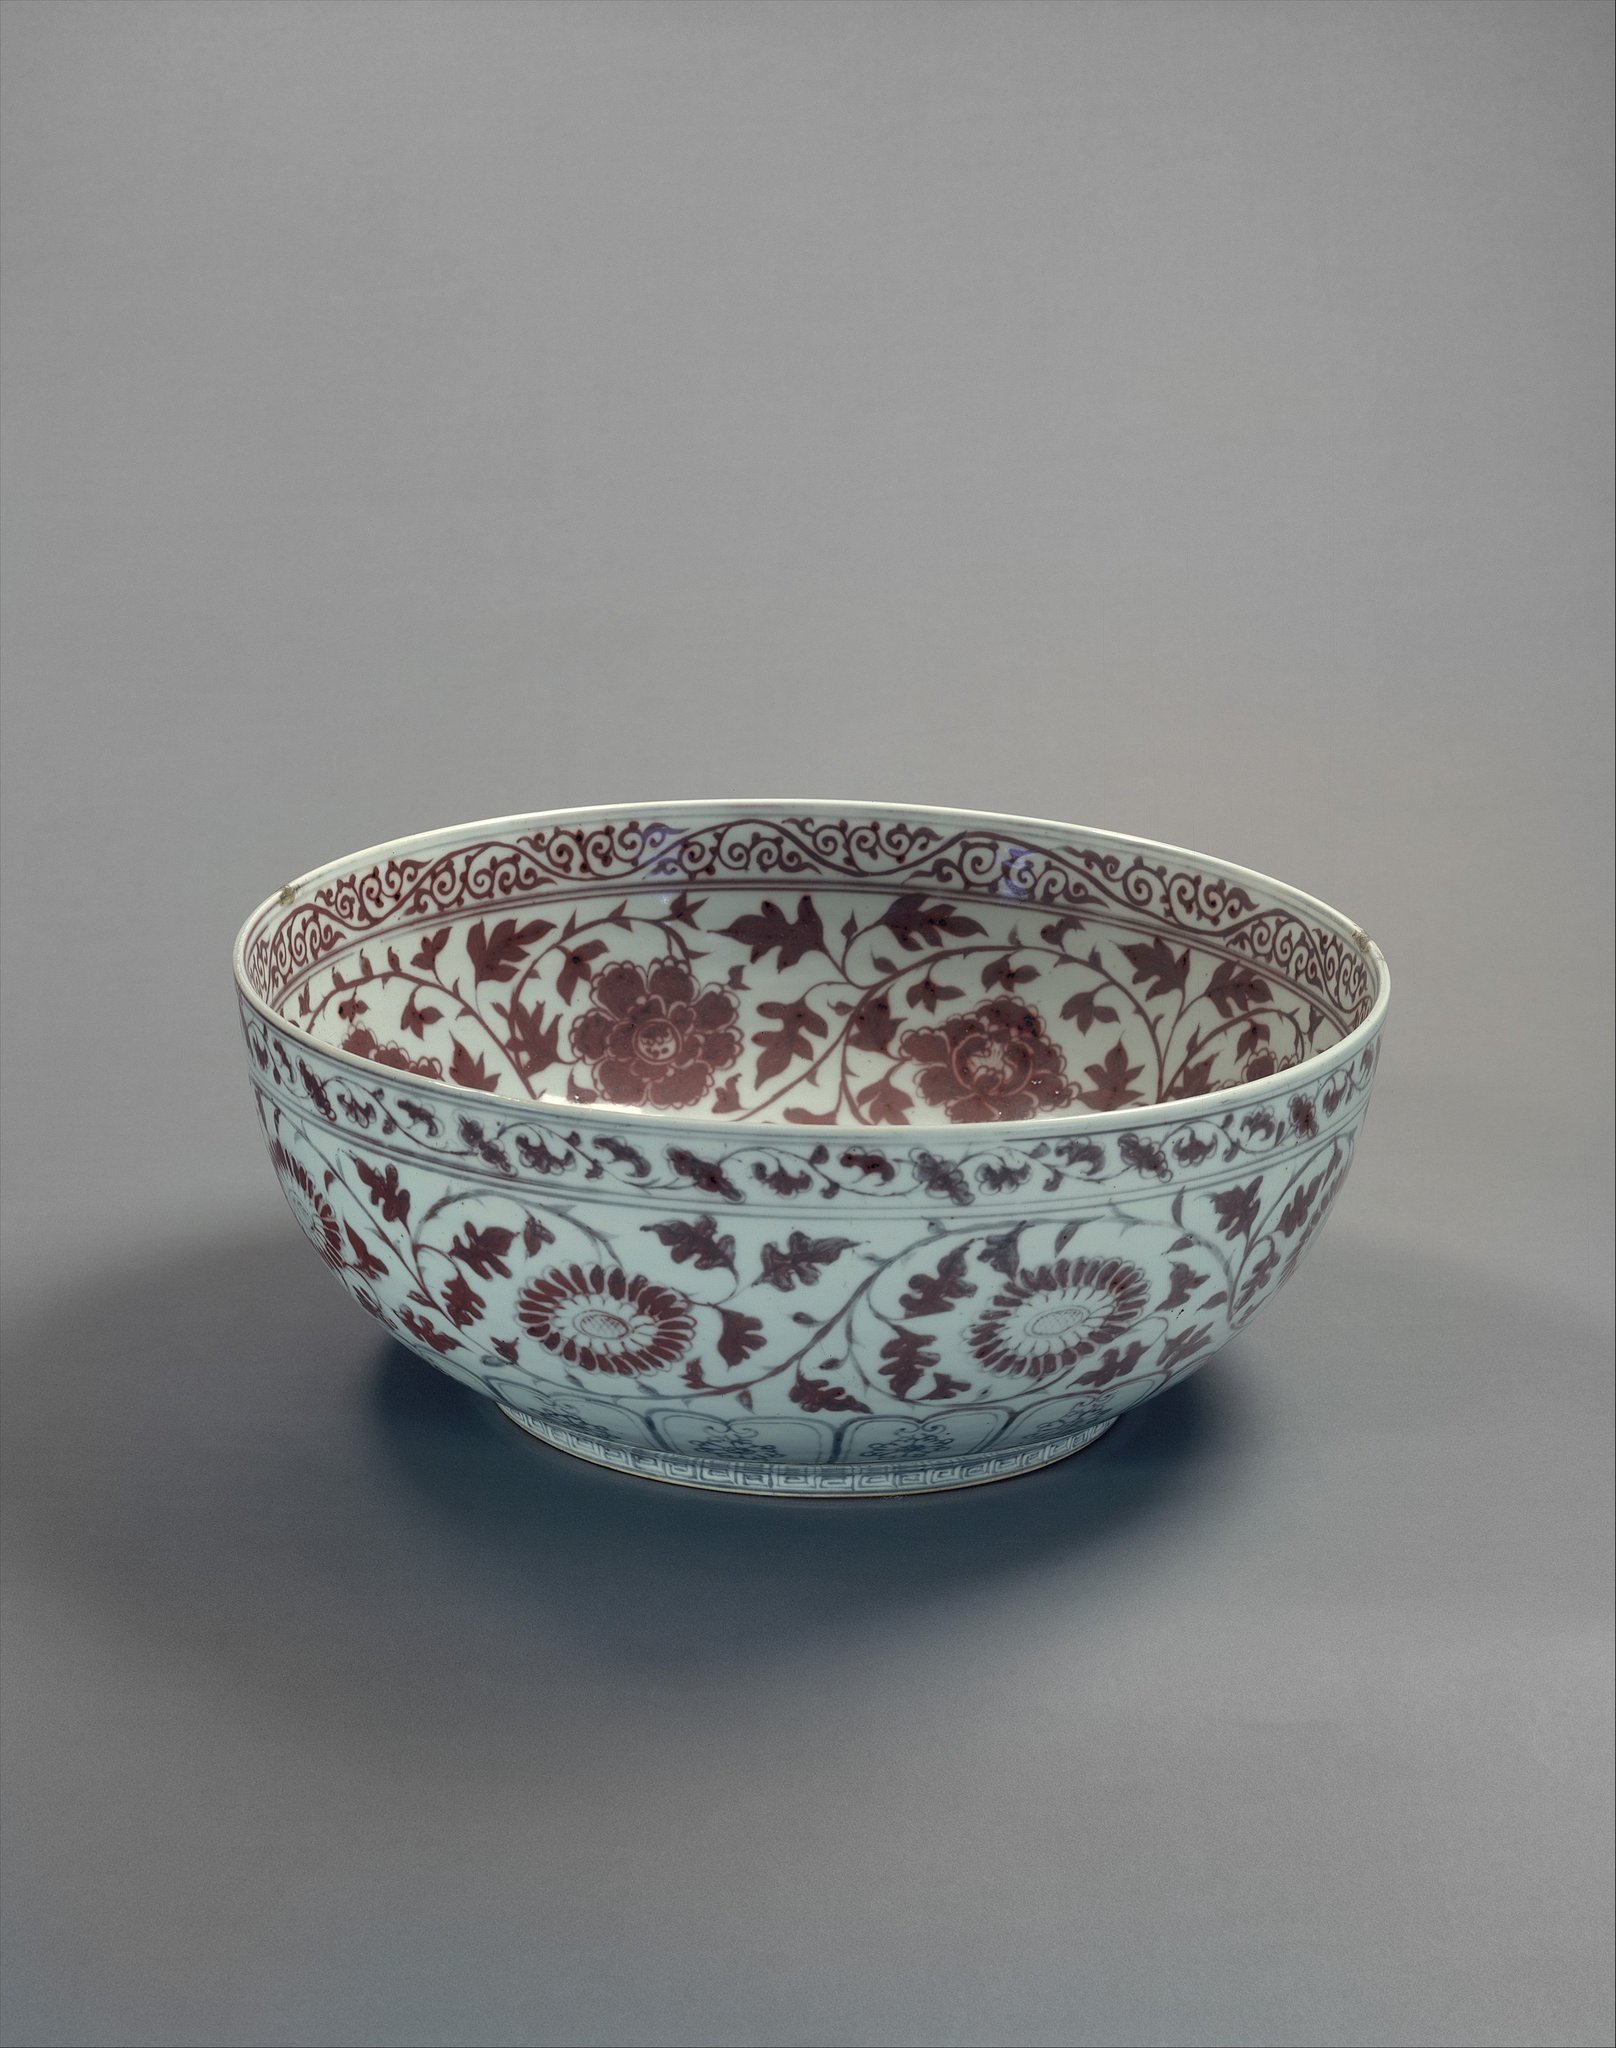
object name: bowl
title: Bowl with Chrysanthemums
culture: chinese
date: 1367-1400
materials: copper, glaze, porcelain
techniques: painting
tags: flowers,leaves